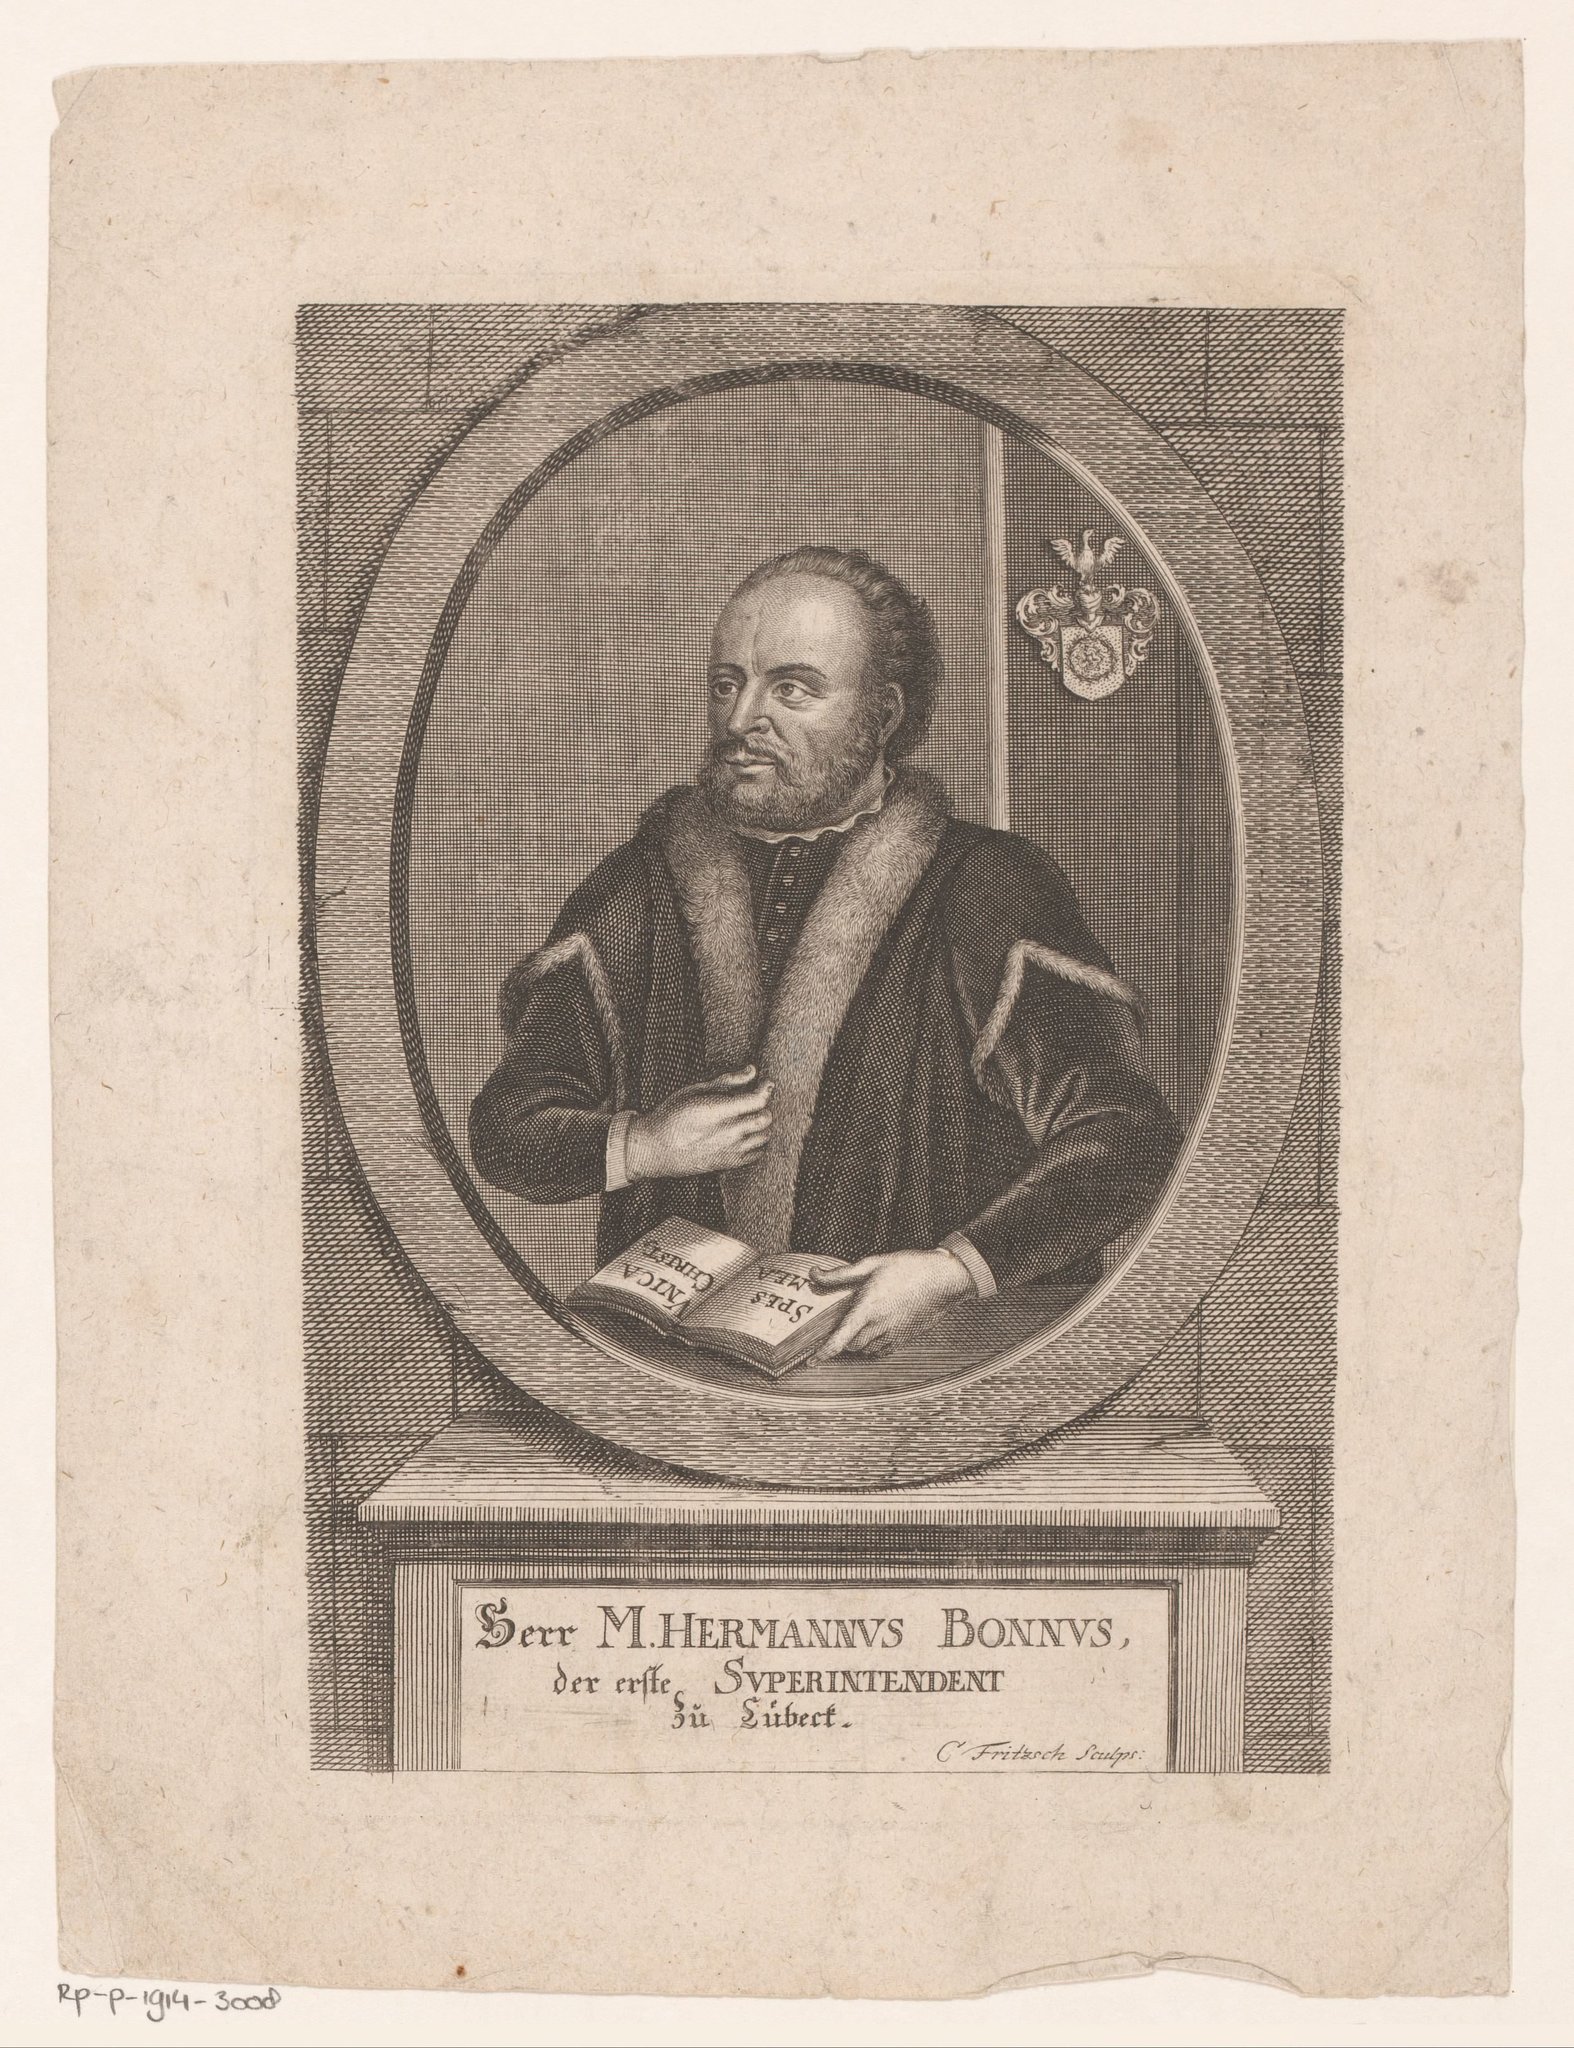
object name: print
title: Portret van Hermann Bonnus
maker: christian fritzsch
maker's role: print maker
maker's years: 1695-1769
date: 1705-1769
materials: paper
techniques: engraving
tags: ornament ~ medallion, historical persons, armorial bearing, heraldry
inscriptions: collector's mark: Lugt 2228